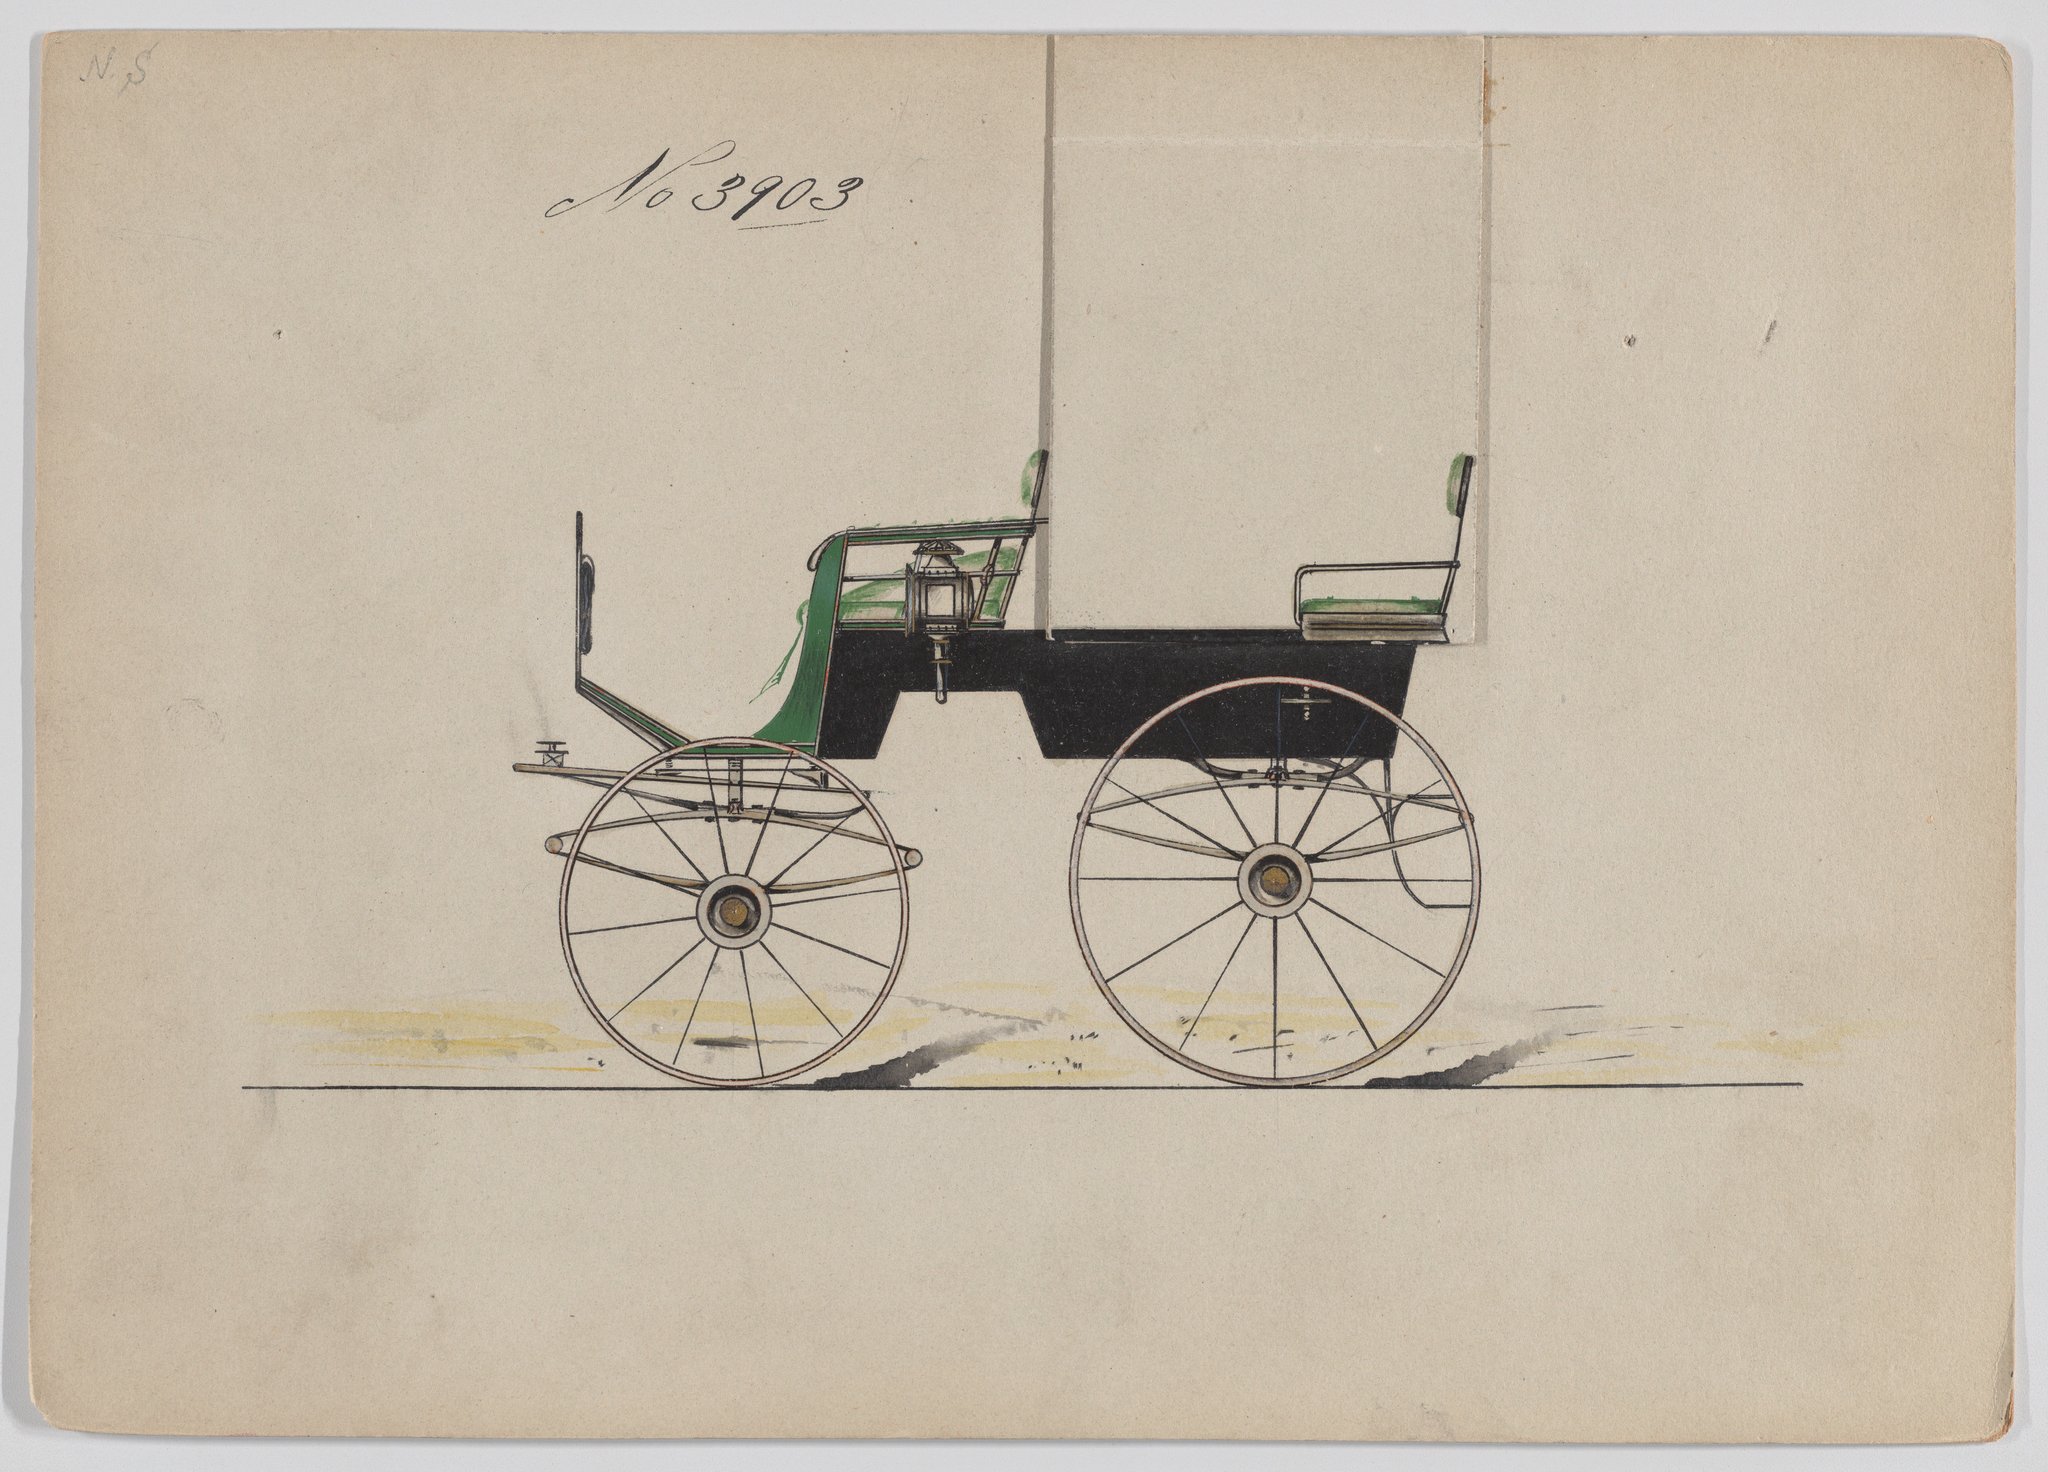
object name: drawing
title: Design for T-Cart, no. 3903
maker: brewster & co.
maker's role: manufacturer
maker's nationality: american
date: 1884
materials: gum arabic, ink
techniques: pen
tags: carriages